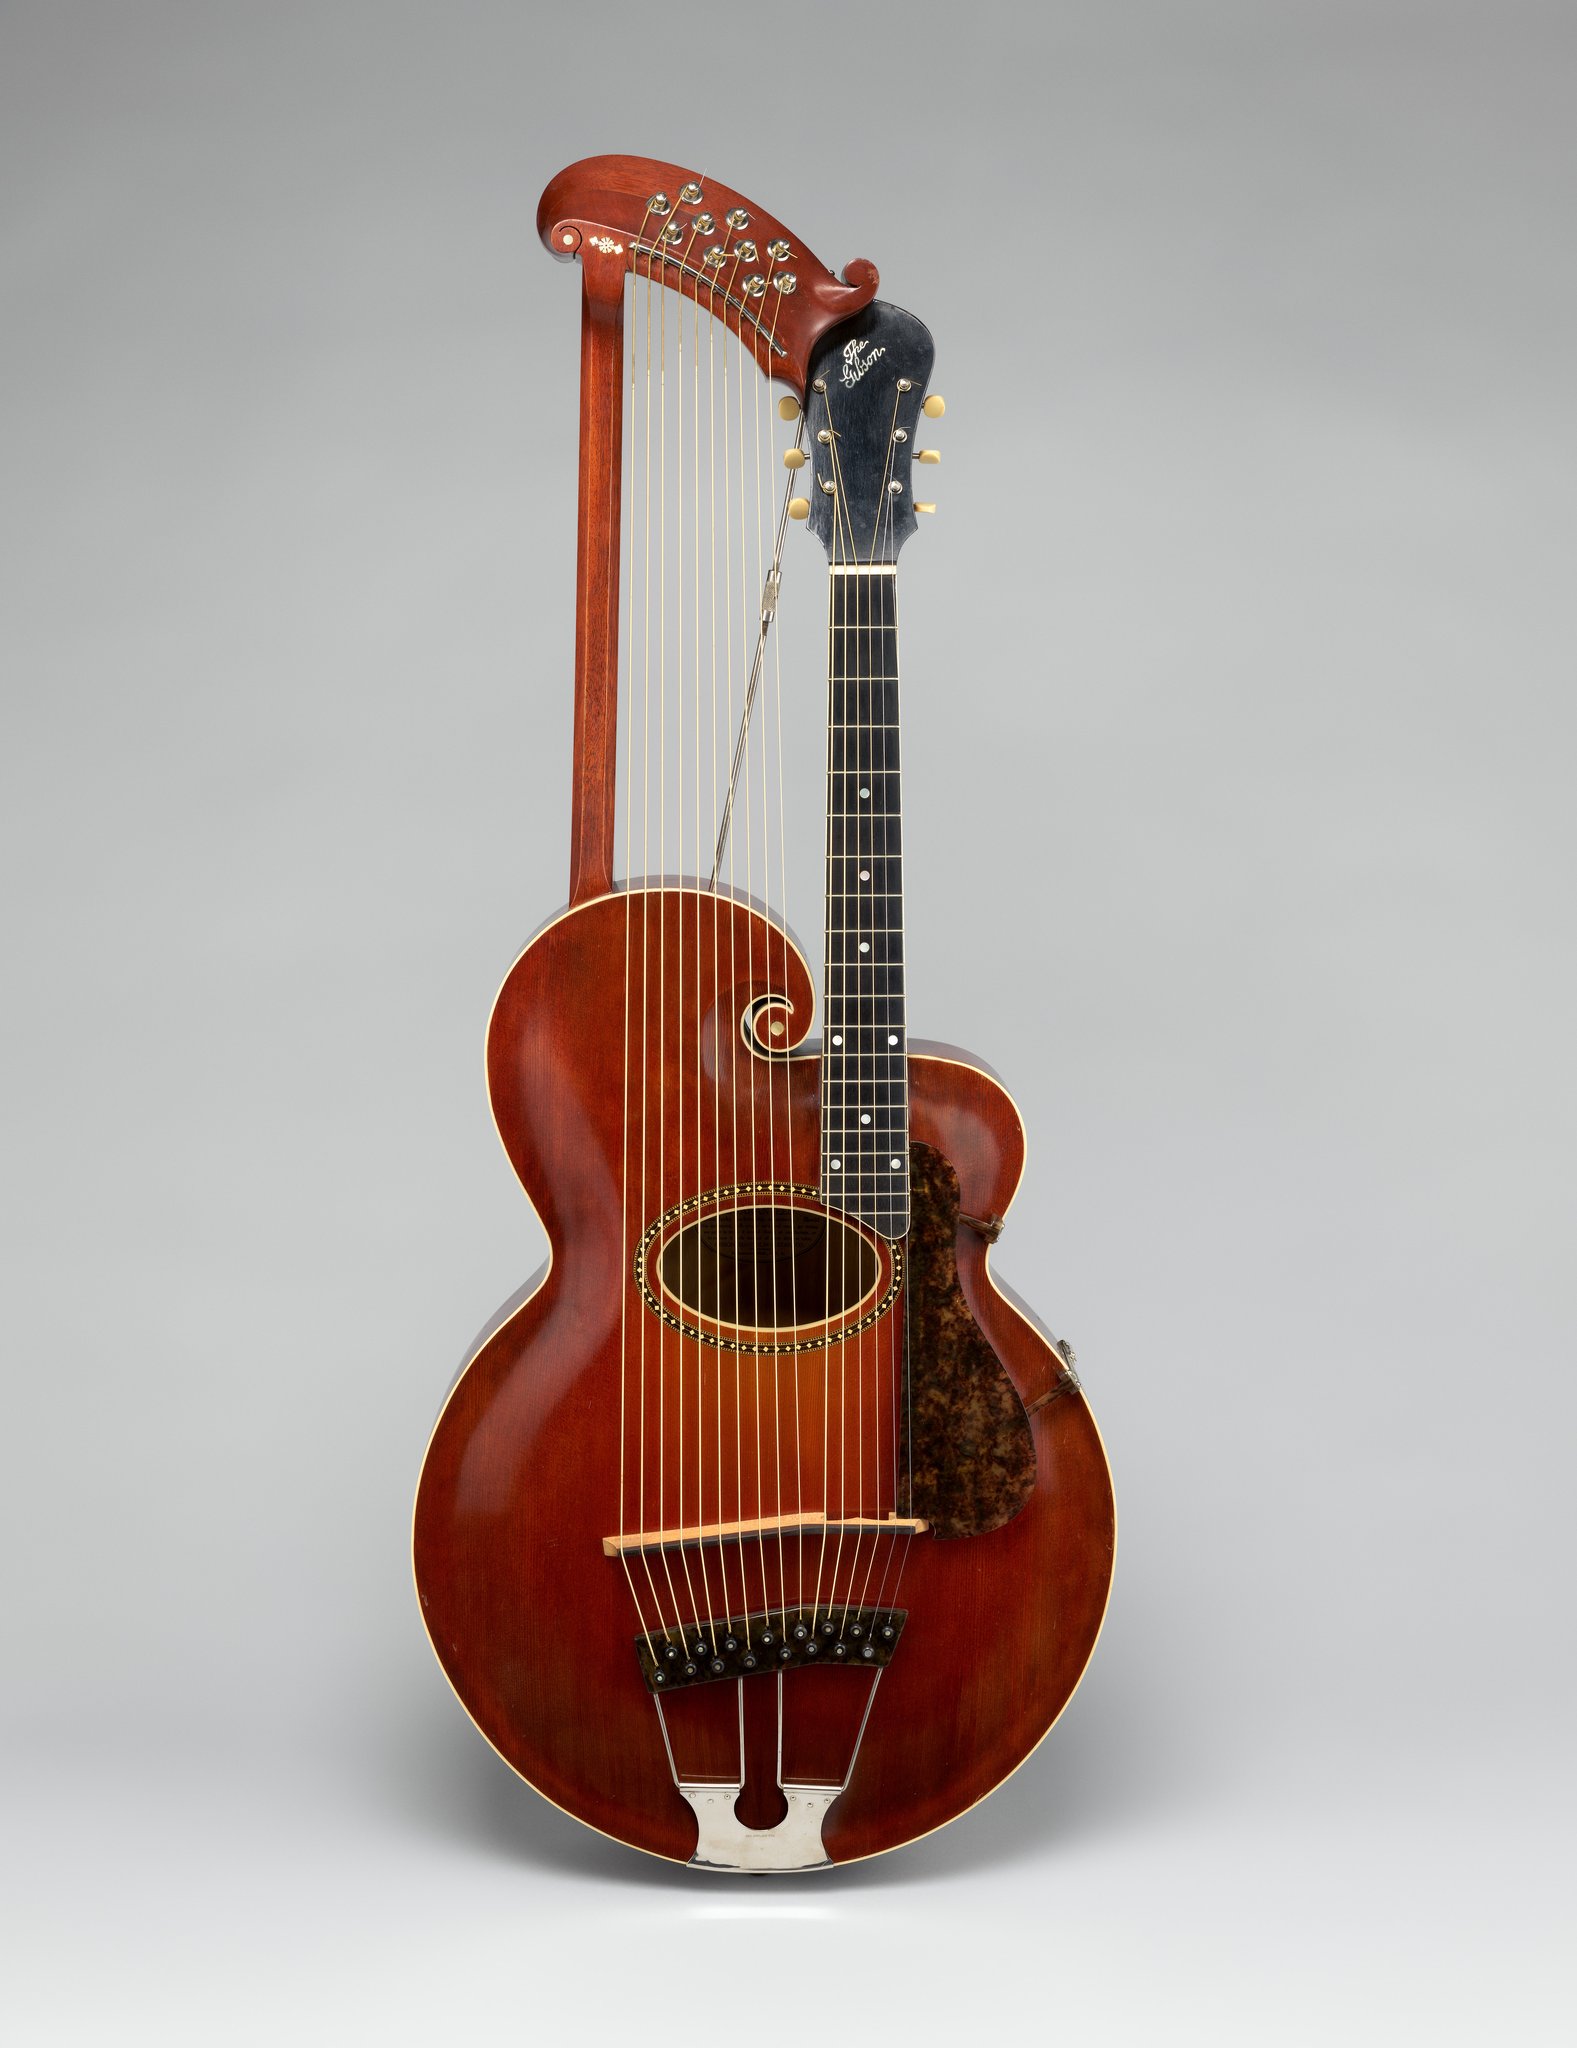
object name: harp guitar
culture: american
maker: gibson mandolin-guitar manufacturing co., ltd.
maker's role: maker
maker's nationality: american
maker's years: 1902-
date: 1917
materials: wood, mother of pearl, nickel, silver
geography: united states